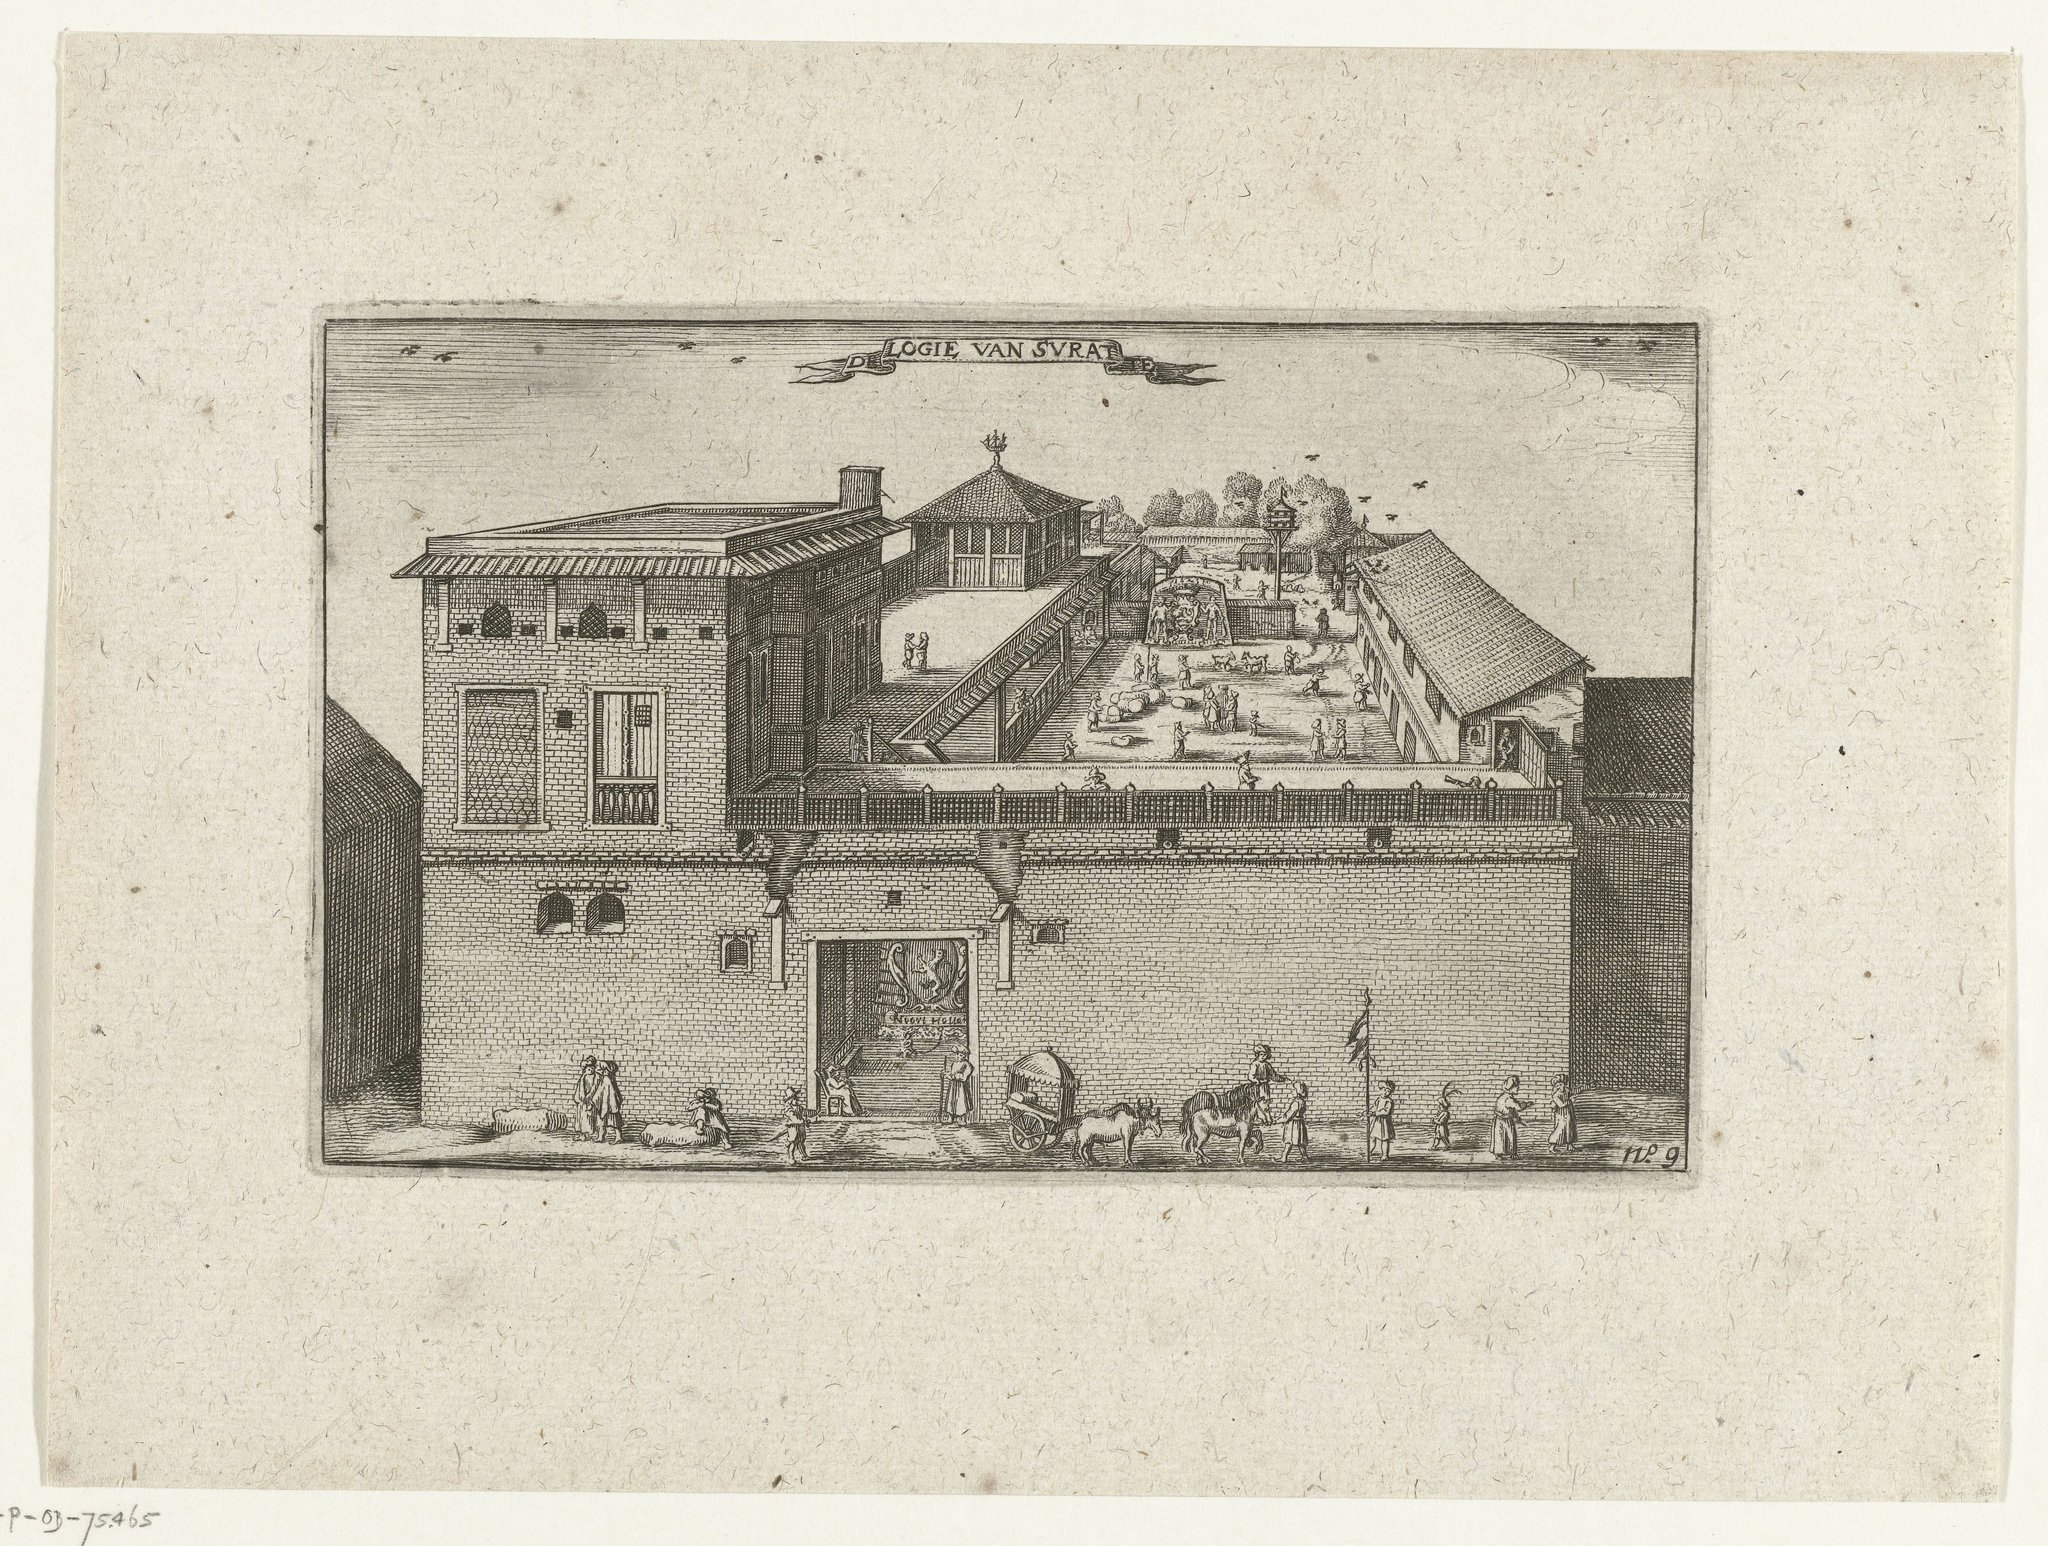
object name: print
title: Logie van Suratte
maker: adriaen matham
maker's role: draughtsman, print maker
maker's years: 1599-1660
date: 1632-1634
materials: paper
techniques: engraving, etching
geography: northern netherlands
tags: antwerp, pieter van den broecke, landscapes in tropical and sub-tropical regions, exploration, expedition, voyage of discovery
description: Gebruikt als illustratie eerst in: P. van den Broecke, Korte historiael ende journaelsche aenteyckeninghe, van al 'tgheen merck-waerdich voorgevallen is, in de langhduerighe reysen, soo nae Cabo Verde, Angola, &c. als insonderheydt van Oost-Indien, Hans Passchiers van Wesbusch, Haarlem, 1634. In deze staat gebruikt in : I. Commelin, Begin ende voortgangh, van de Vereenighde Nederlantsche Geoctroyeerde Oost-Indische Compagnie, J. Janssonius, Amsterdam 1646. Genummerd: No. 9.